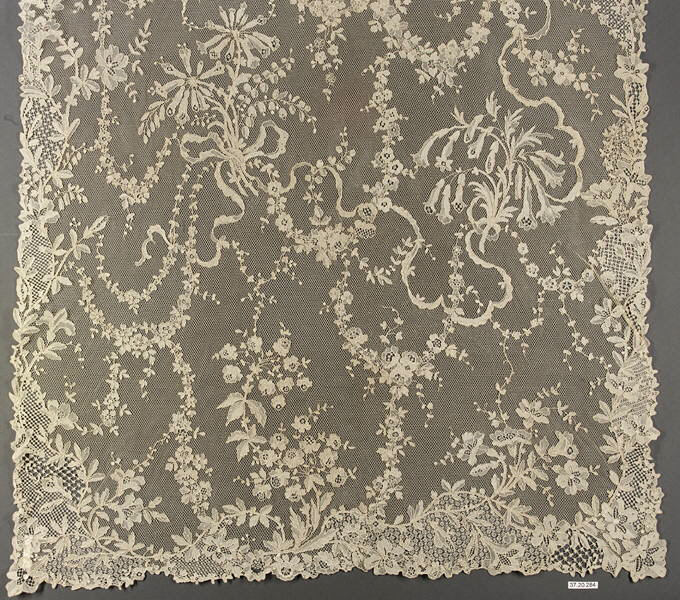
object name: scarf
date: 1801-1900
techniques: lace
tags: flowers